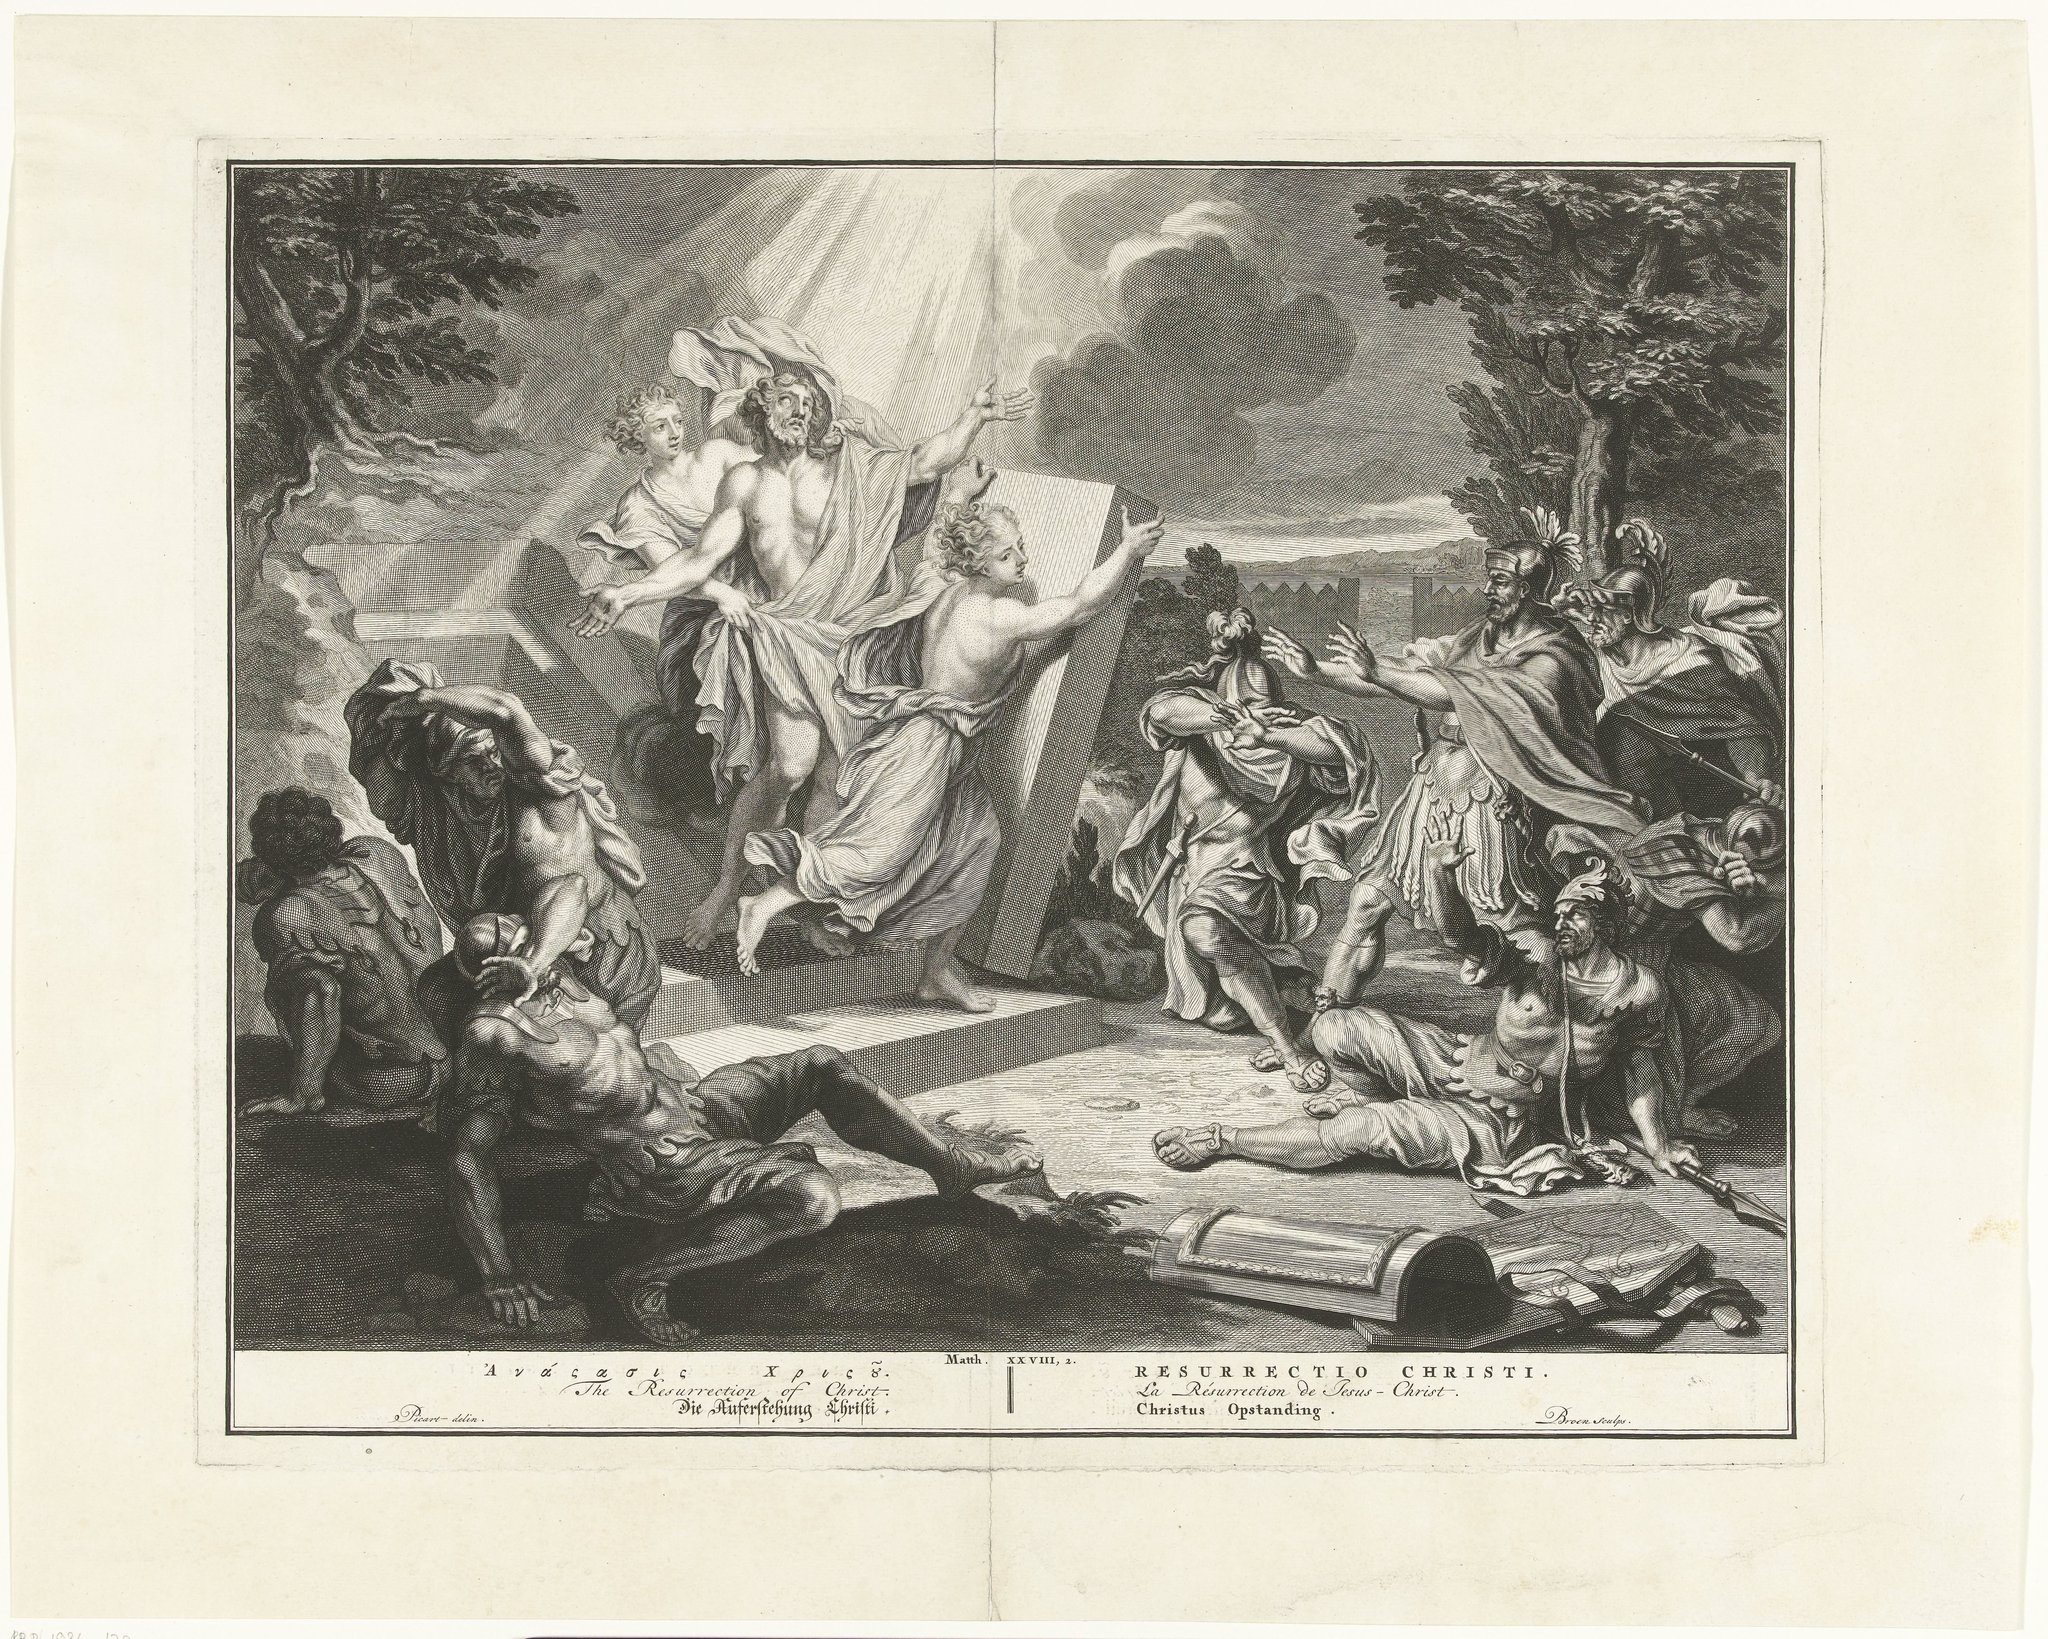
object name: print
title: Christus opstanding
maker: bernard picart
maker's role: draughtsman, print maker, publisher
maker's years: 1673-1733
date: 1711-1720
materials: paper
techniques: engraving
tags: christ stepping out of the tomb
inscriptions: inscription: ‘Utrechts Fundatie huys’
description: gemaakt voor: Figures de la Bible, Amsterdam, B. Picart, 1720. ook gebruikt voor: Taferelen der voornaamste geschiedenissen van het Oude en Nieuwe Testament, en andere boeken, bij de Heilige Schrift gevoegt. Den Haag: Pieter de Hondt, 1728.